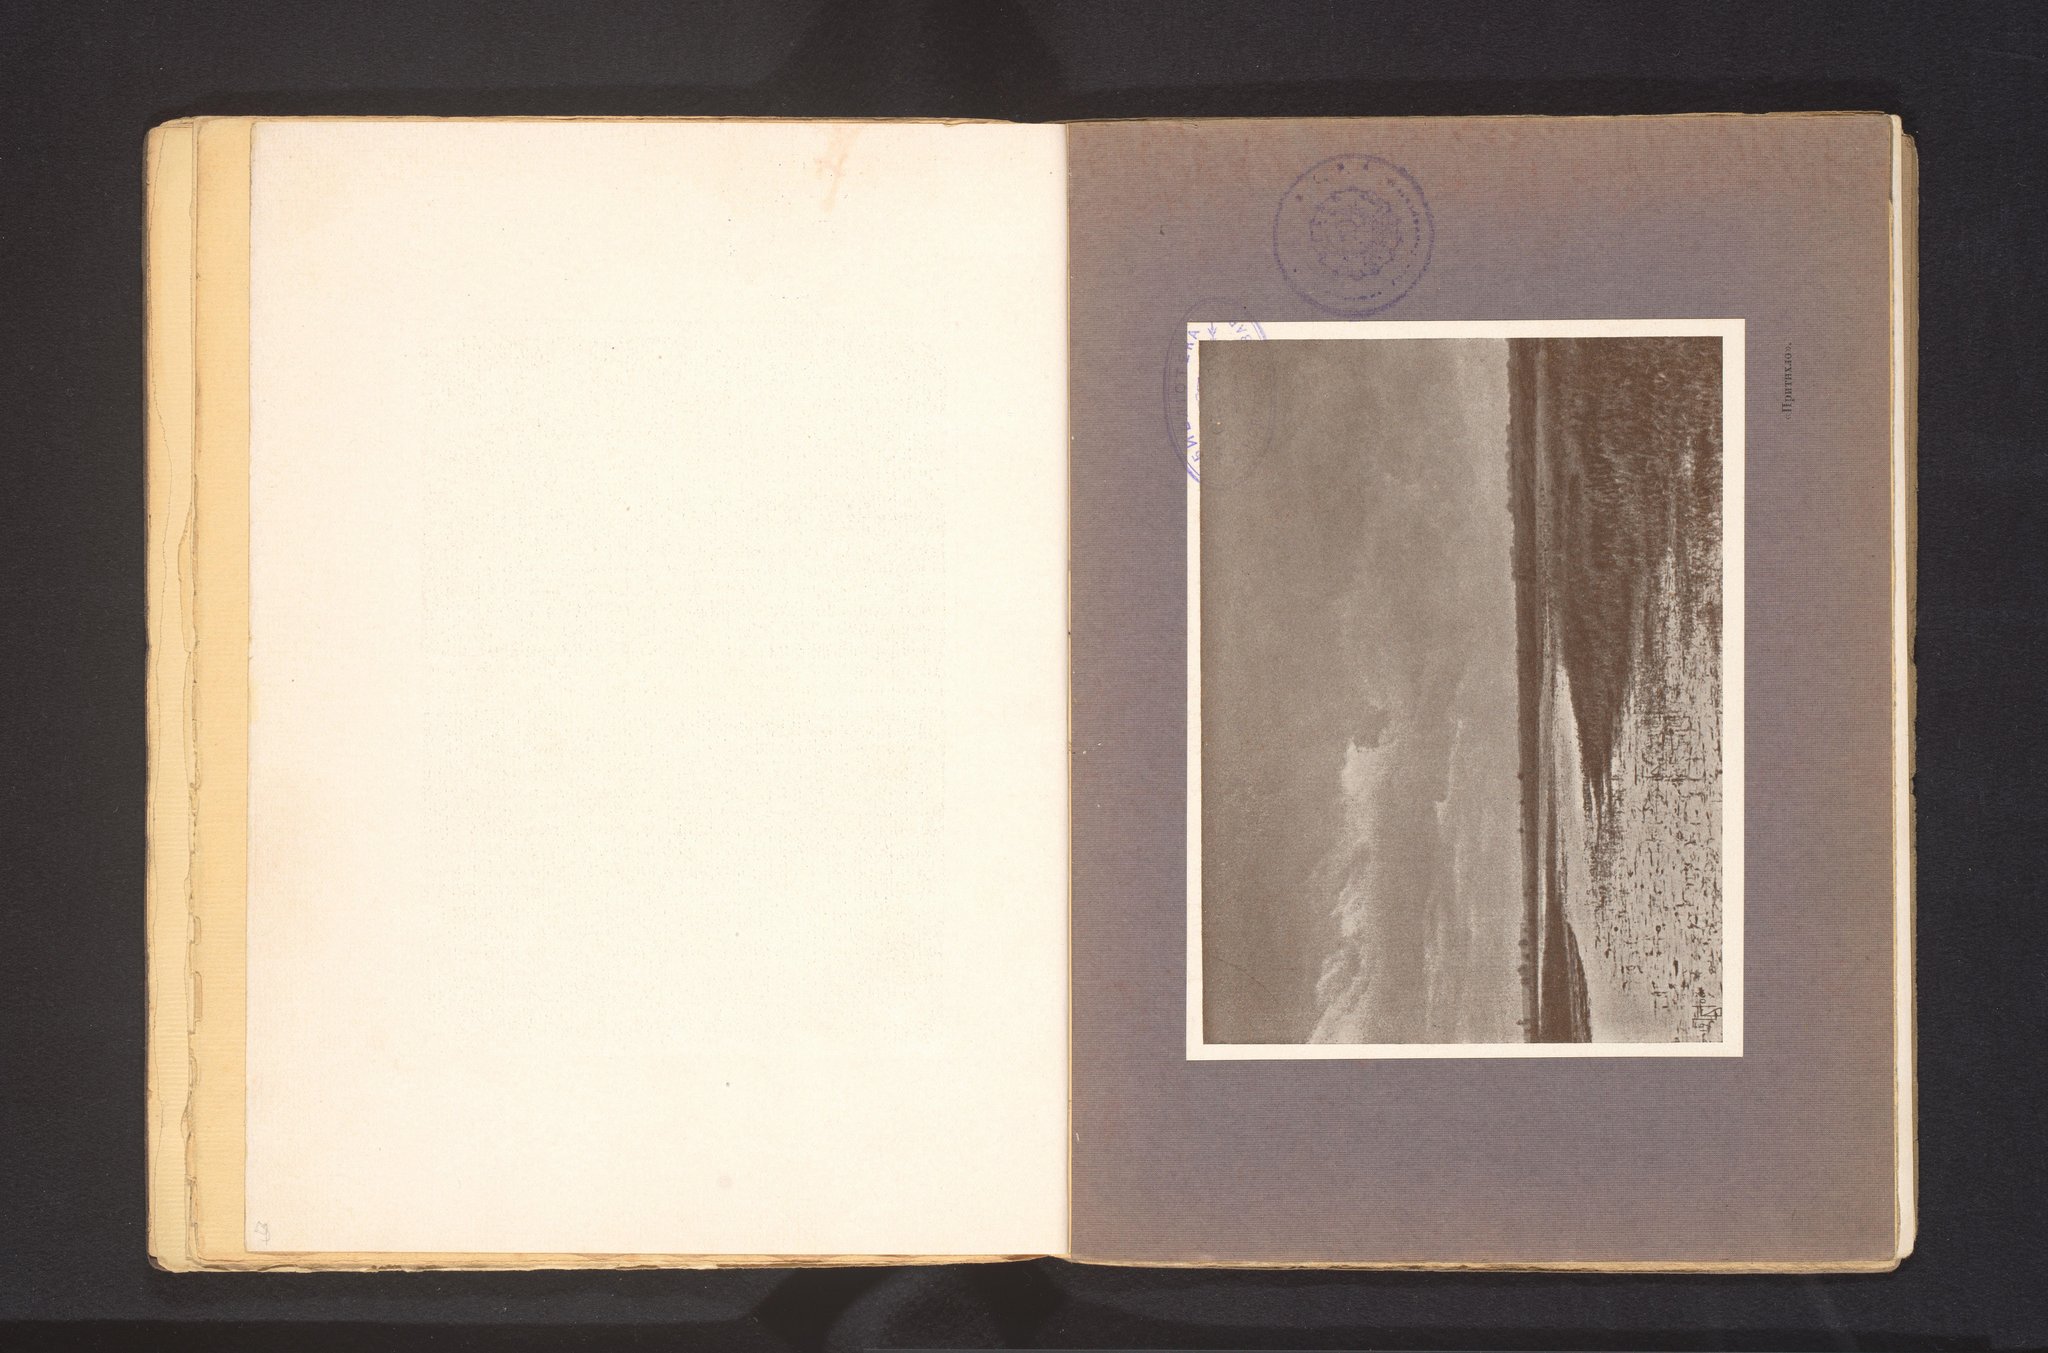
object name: page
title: Притидо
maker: Anonymous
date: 1897-1907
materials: paper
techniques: autotype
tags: river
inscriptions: inscription